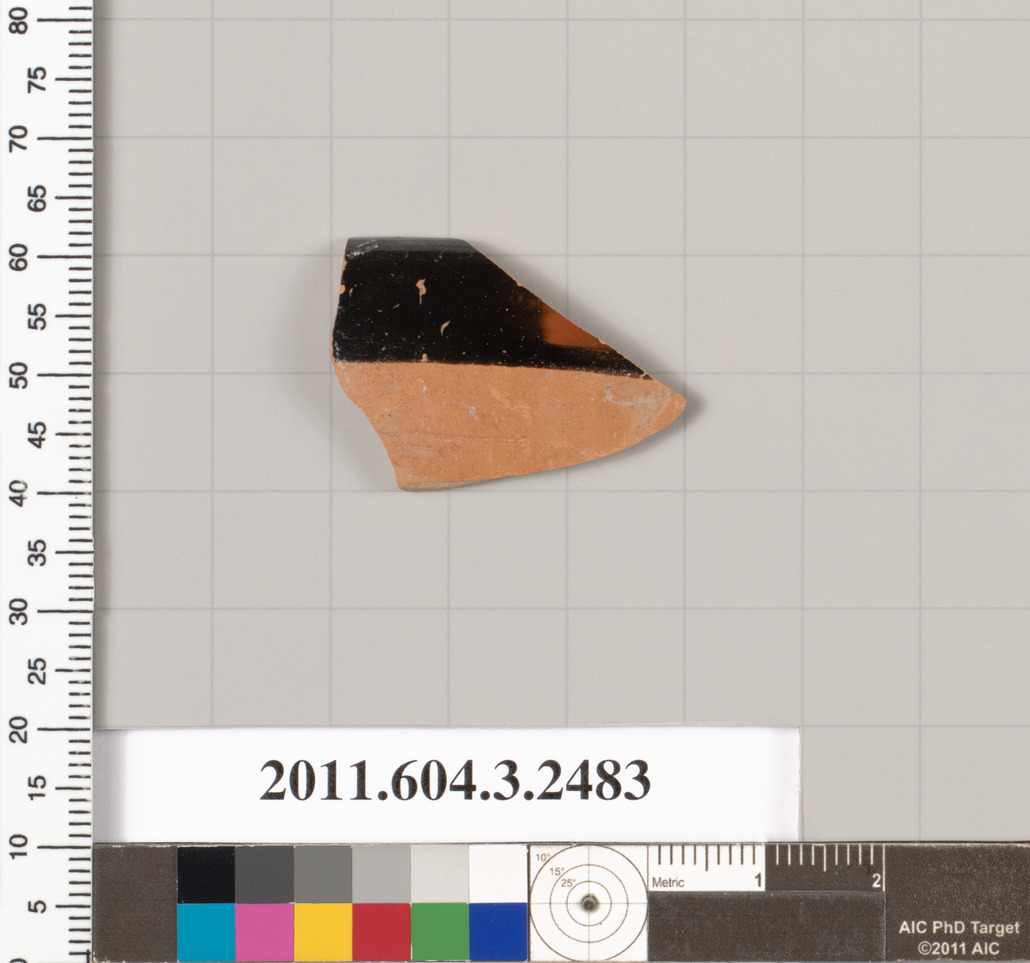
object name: kylix fragment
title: Terracotta rim fragment of a kylix (drinking cup)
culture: greek, attic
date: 600-401 BCE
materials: terracotta